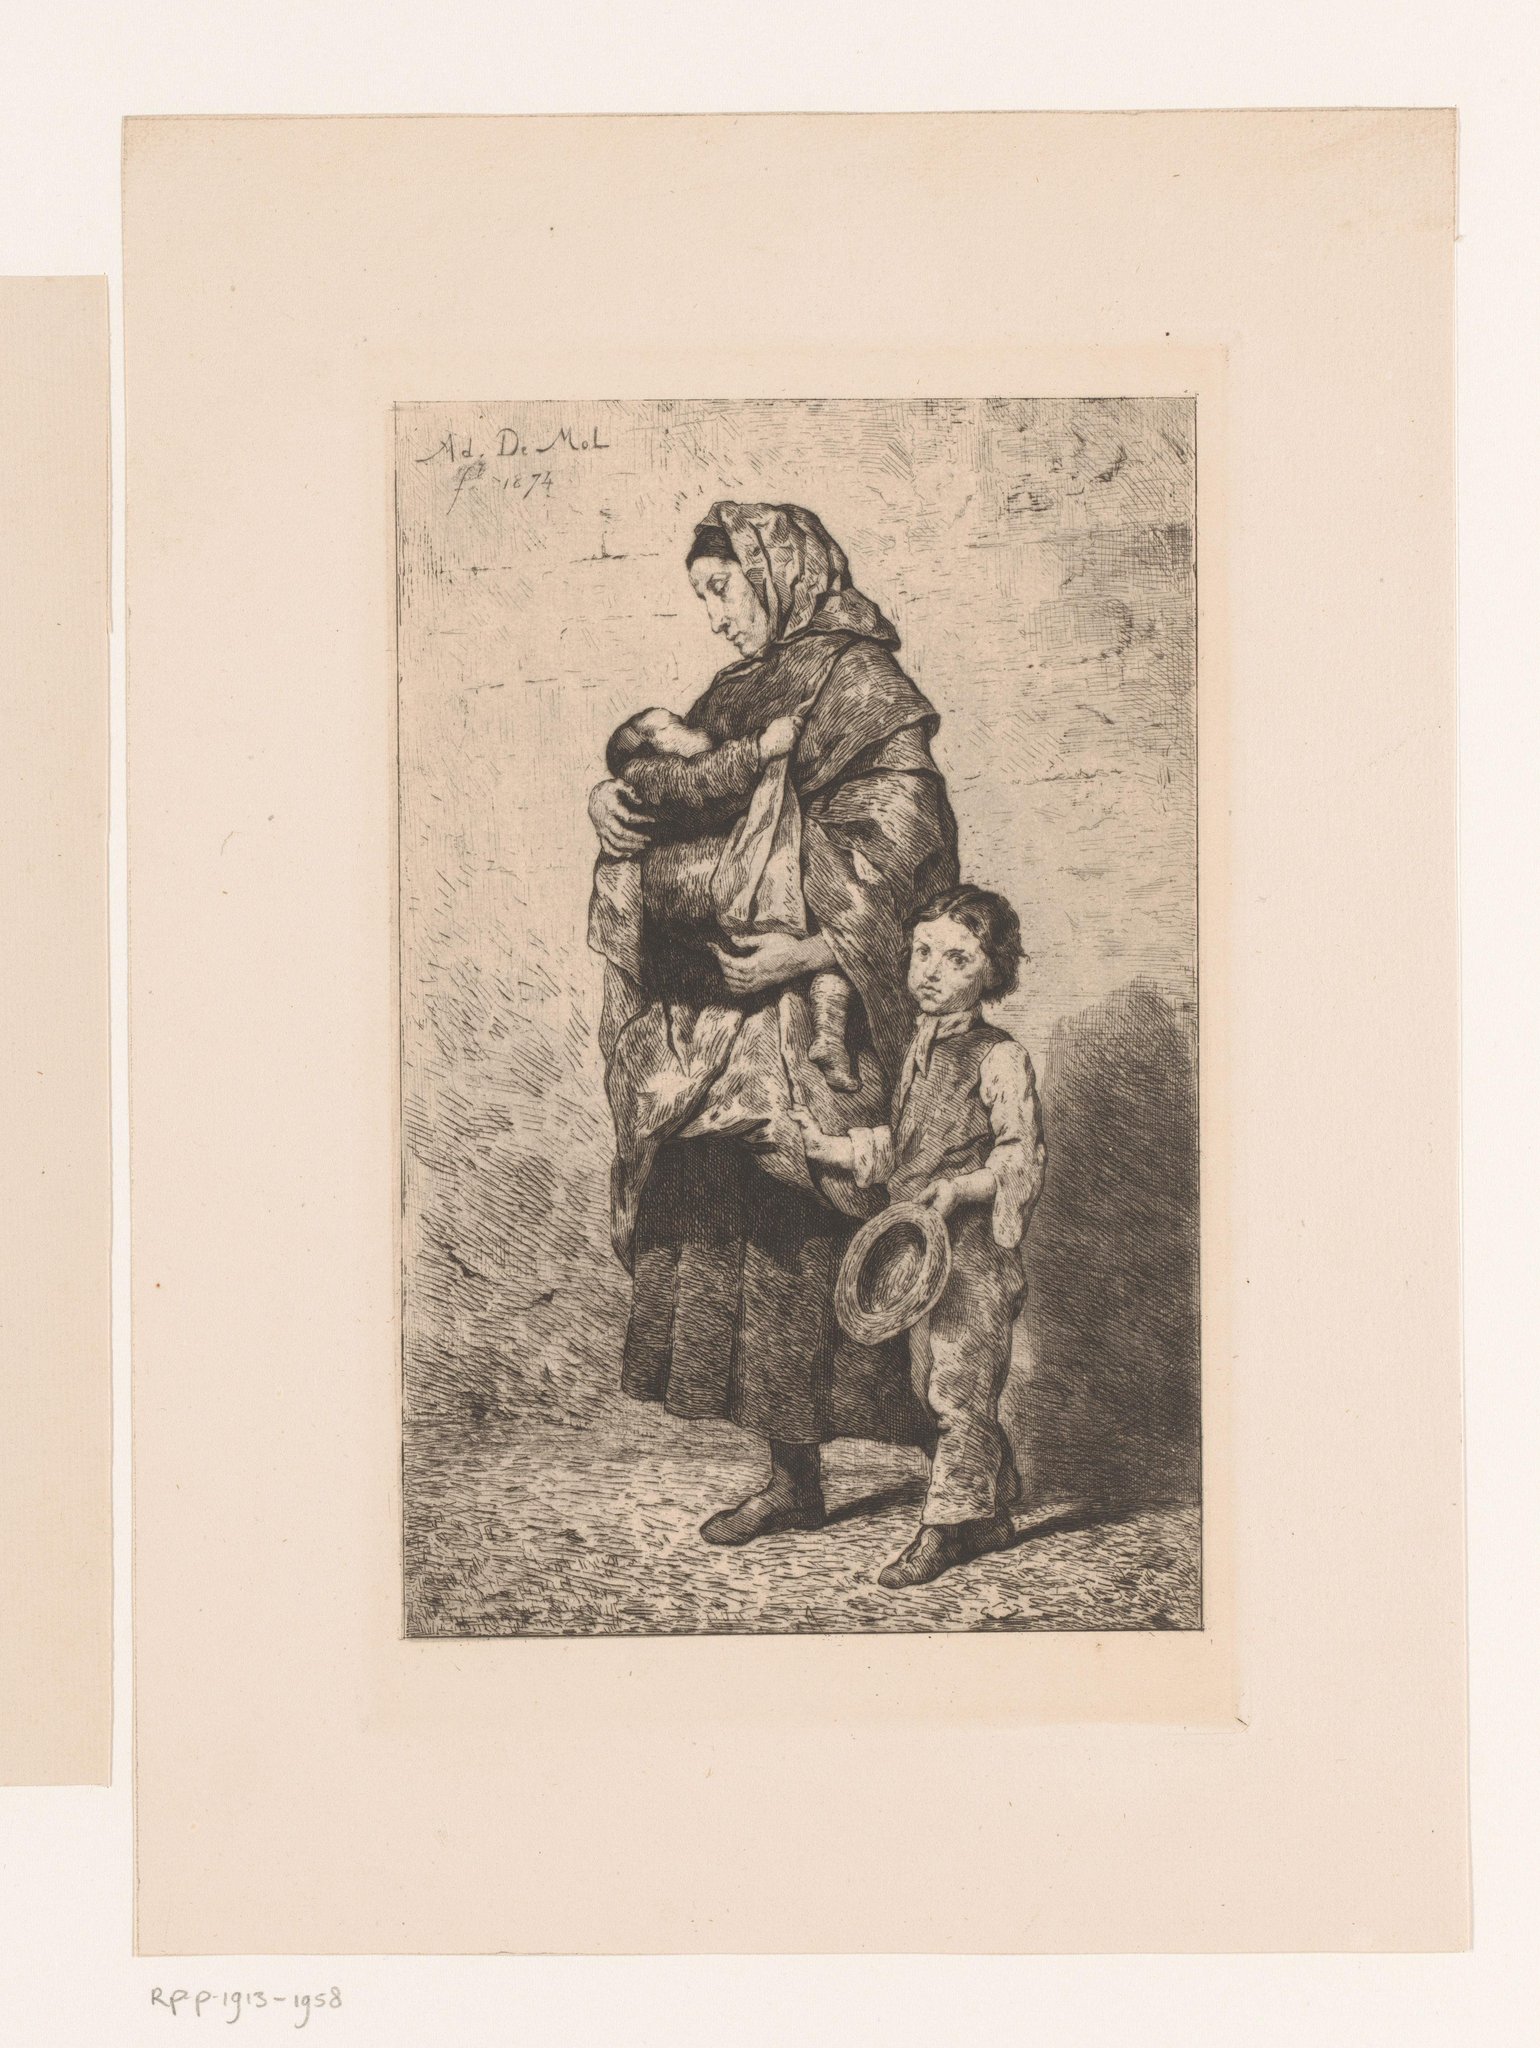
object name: print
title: Vrouw met een kind in haar armen en een jongen naast haar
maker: adolphe léonard de mol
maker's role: print maker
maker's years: 1834-1877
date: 1874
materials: paper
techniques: drypoint, etching, intaglio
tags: mother and child(ren), woman and child(ren) (family group) (with number of children)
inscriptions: collector's mark: Lugt 2228